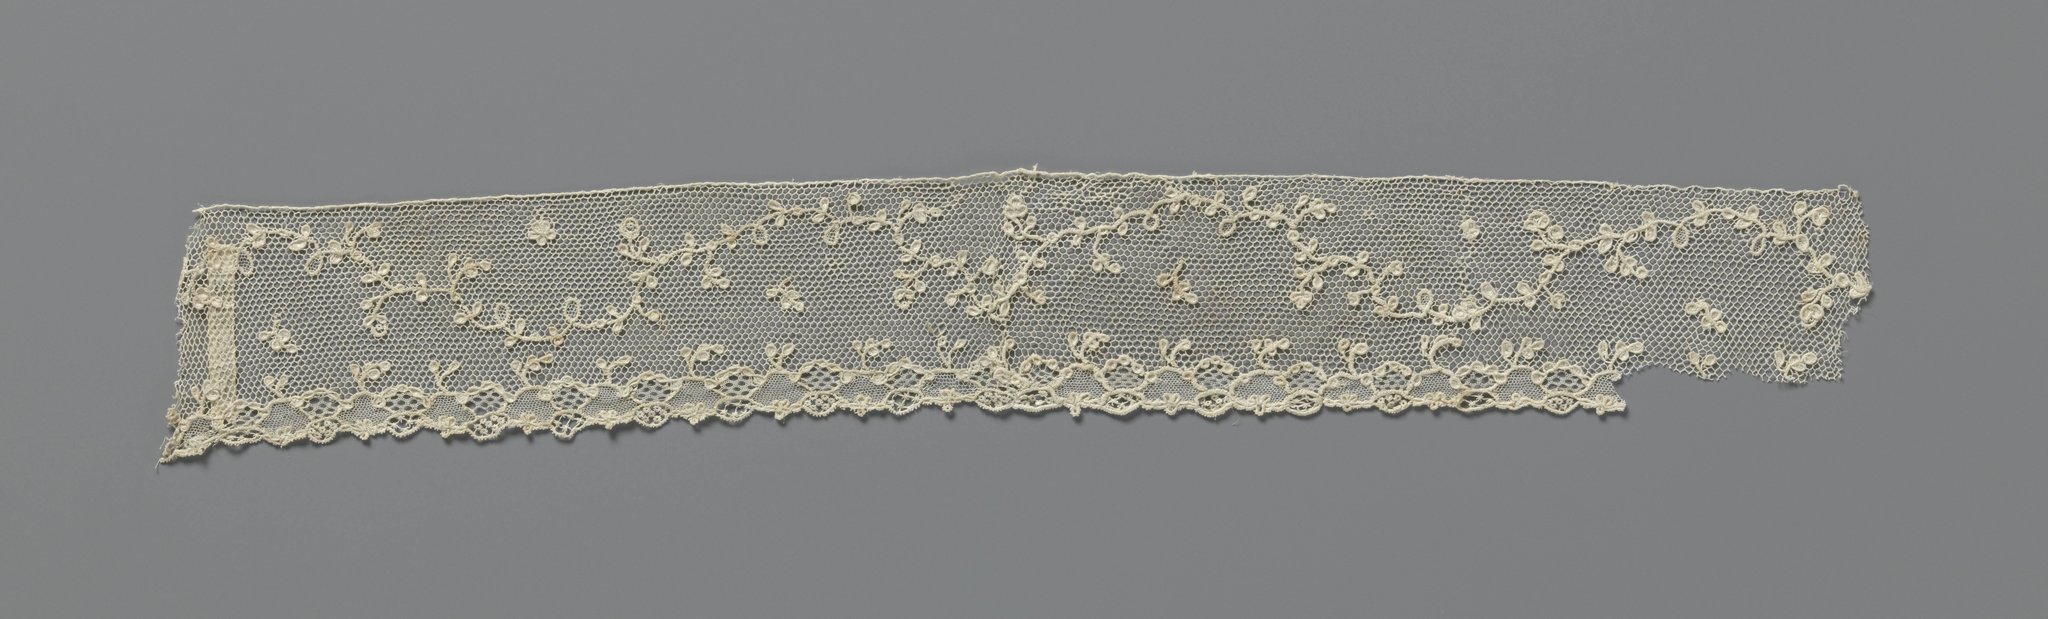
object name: strip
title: Strook naaldkant met slingerende tak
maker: Anonymous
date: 1790-1799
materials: linen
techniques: lace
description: Strook naturelkleurige naaldkant: Alençon-kant. Patroon met een slingerende, doorlopende tak met kleine ovale en ronde bloemen op een fijne zeshoekige maasgrond met enkele strooibloemen. De onderkant van het patroon bestaat uit twee waaiervormige figuren met aan de onderkant een bloempje of een ovaal. De waaiertjes en ovalen zijn met verschillende siersteken opgevuld. De bovenzijde is afgewerkt met een rechte rand. De onderzijde is afgewerkt met een schulpenrand die voortkomt uit het patroon.